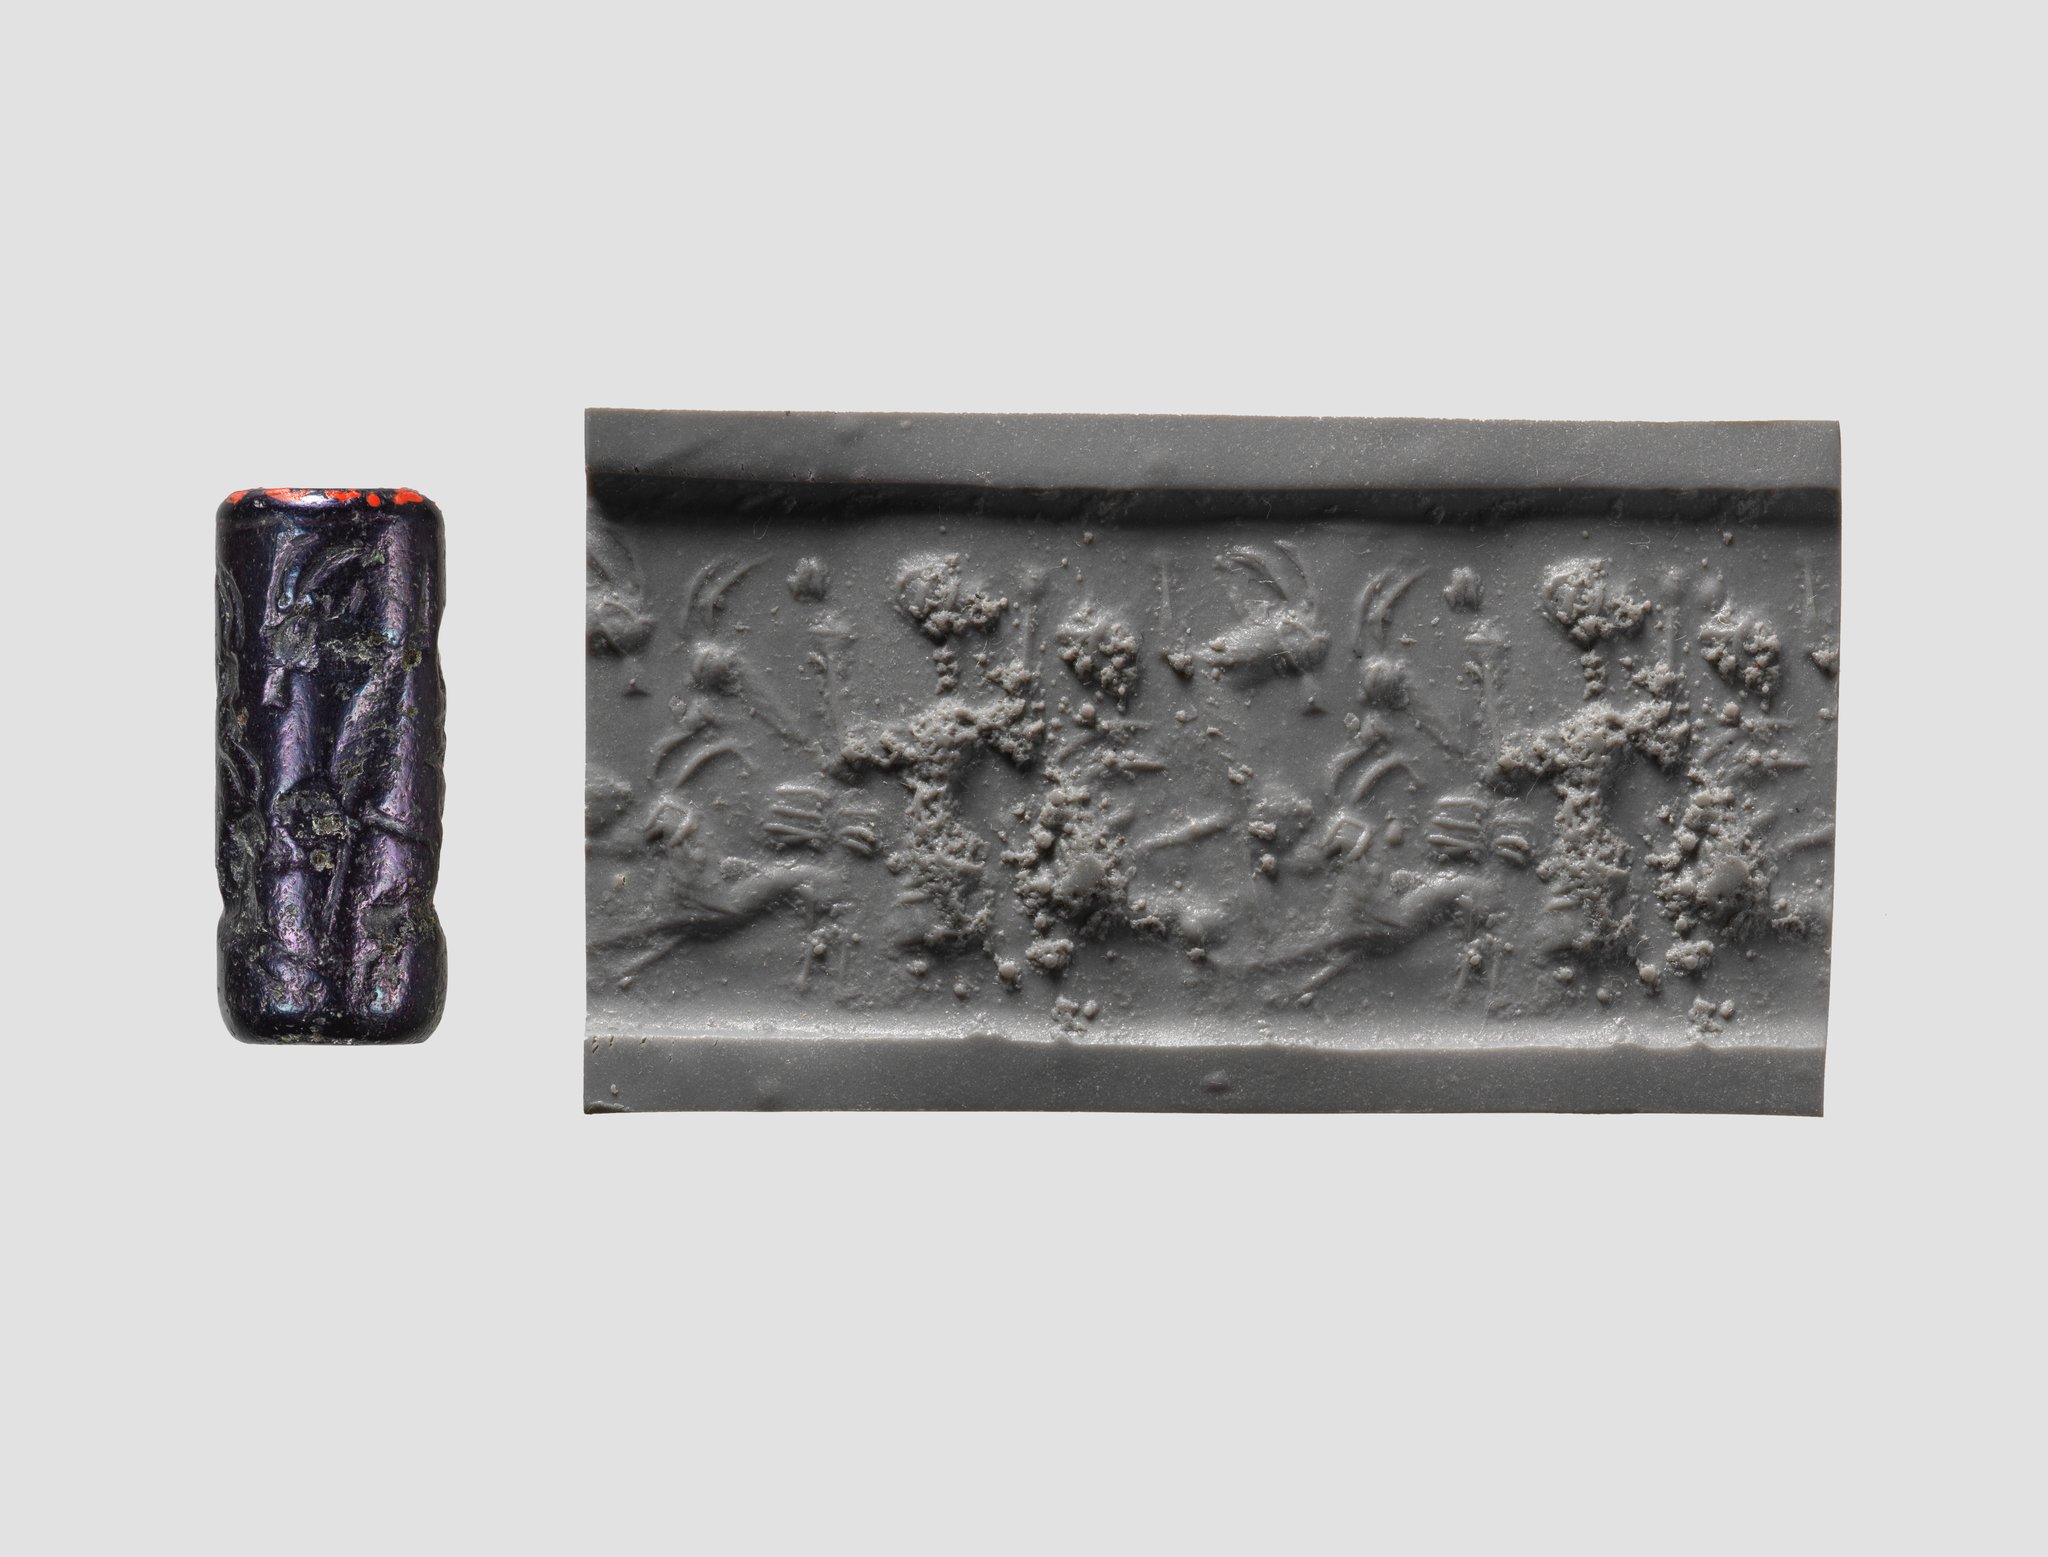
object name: cylinder seal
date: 1333-1001 BCE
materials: mineral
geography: cyprus or syria